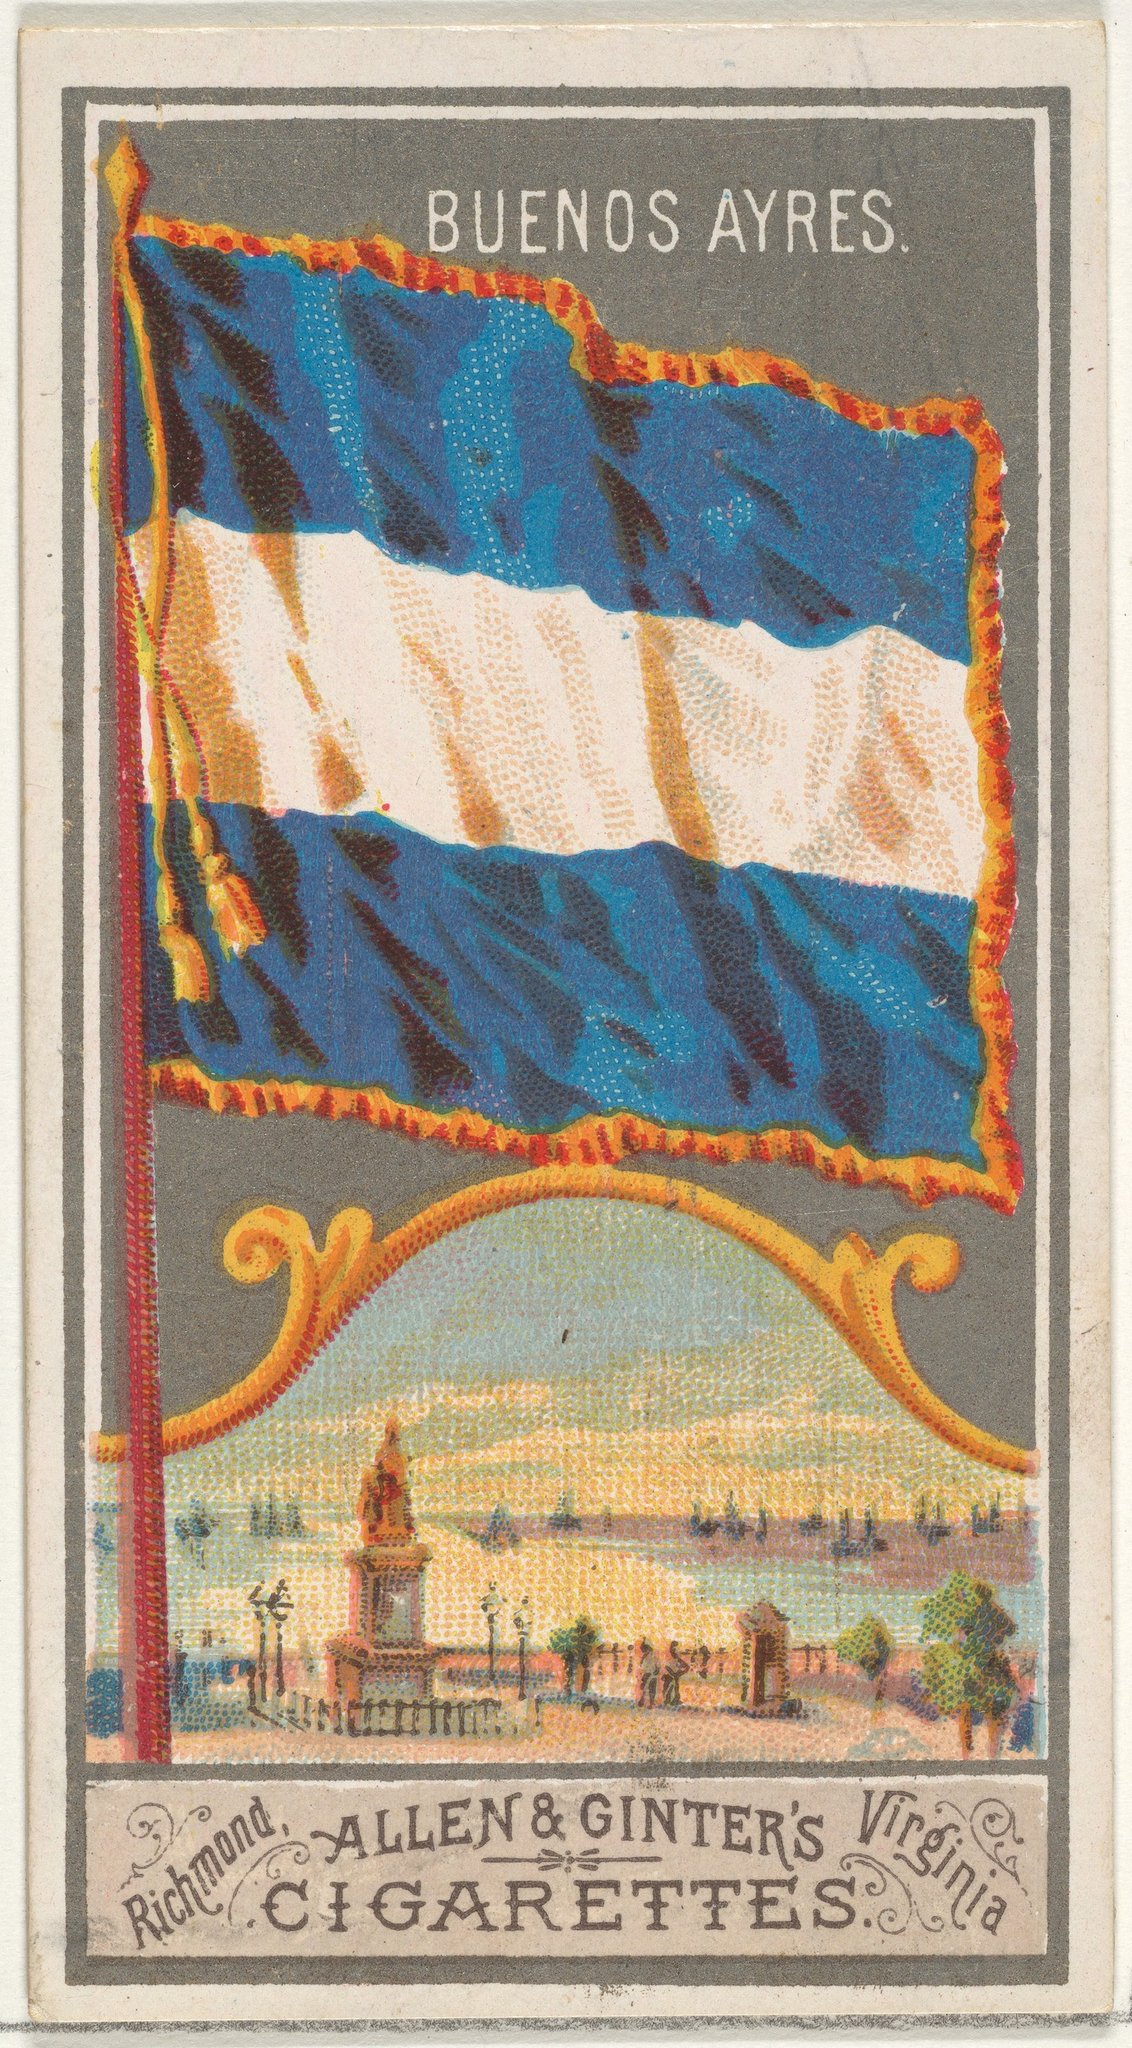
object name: print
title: Buenos Aires, from the City Flags series (N6) for Allen & Ginter Cigarettes Brands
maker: allen & ginter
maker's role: publisher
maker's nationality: american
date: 1887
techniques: color lithograph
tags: flags